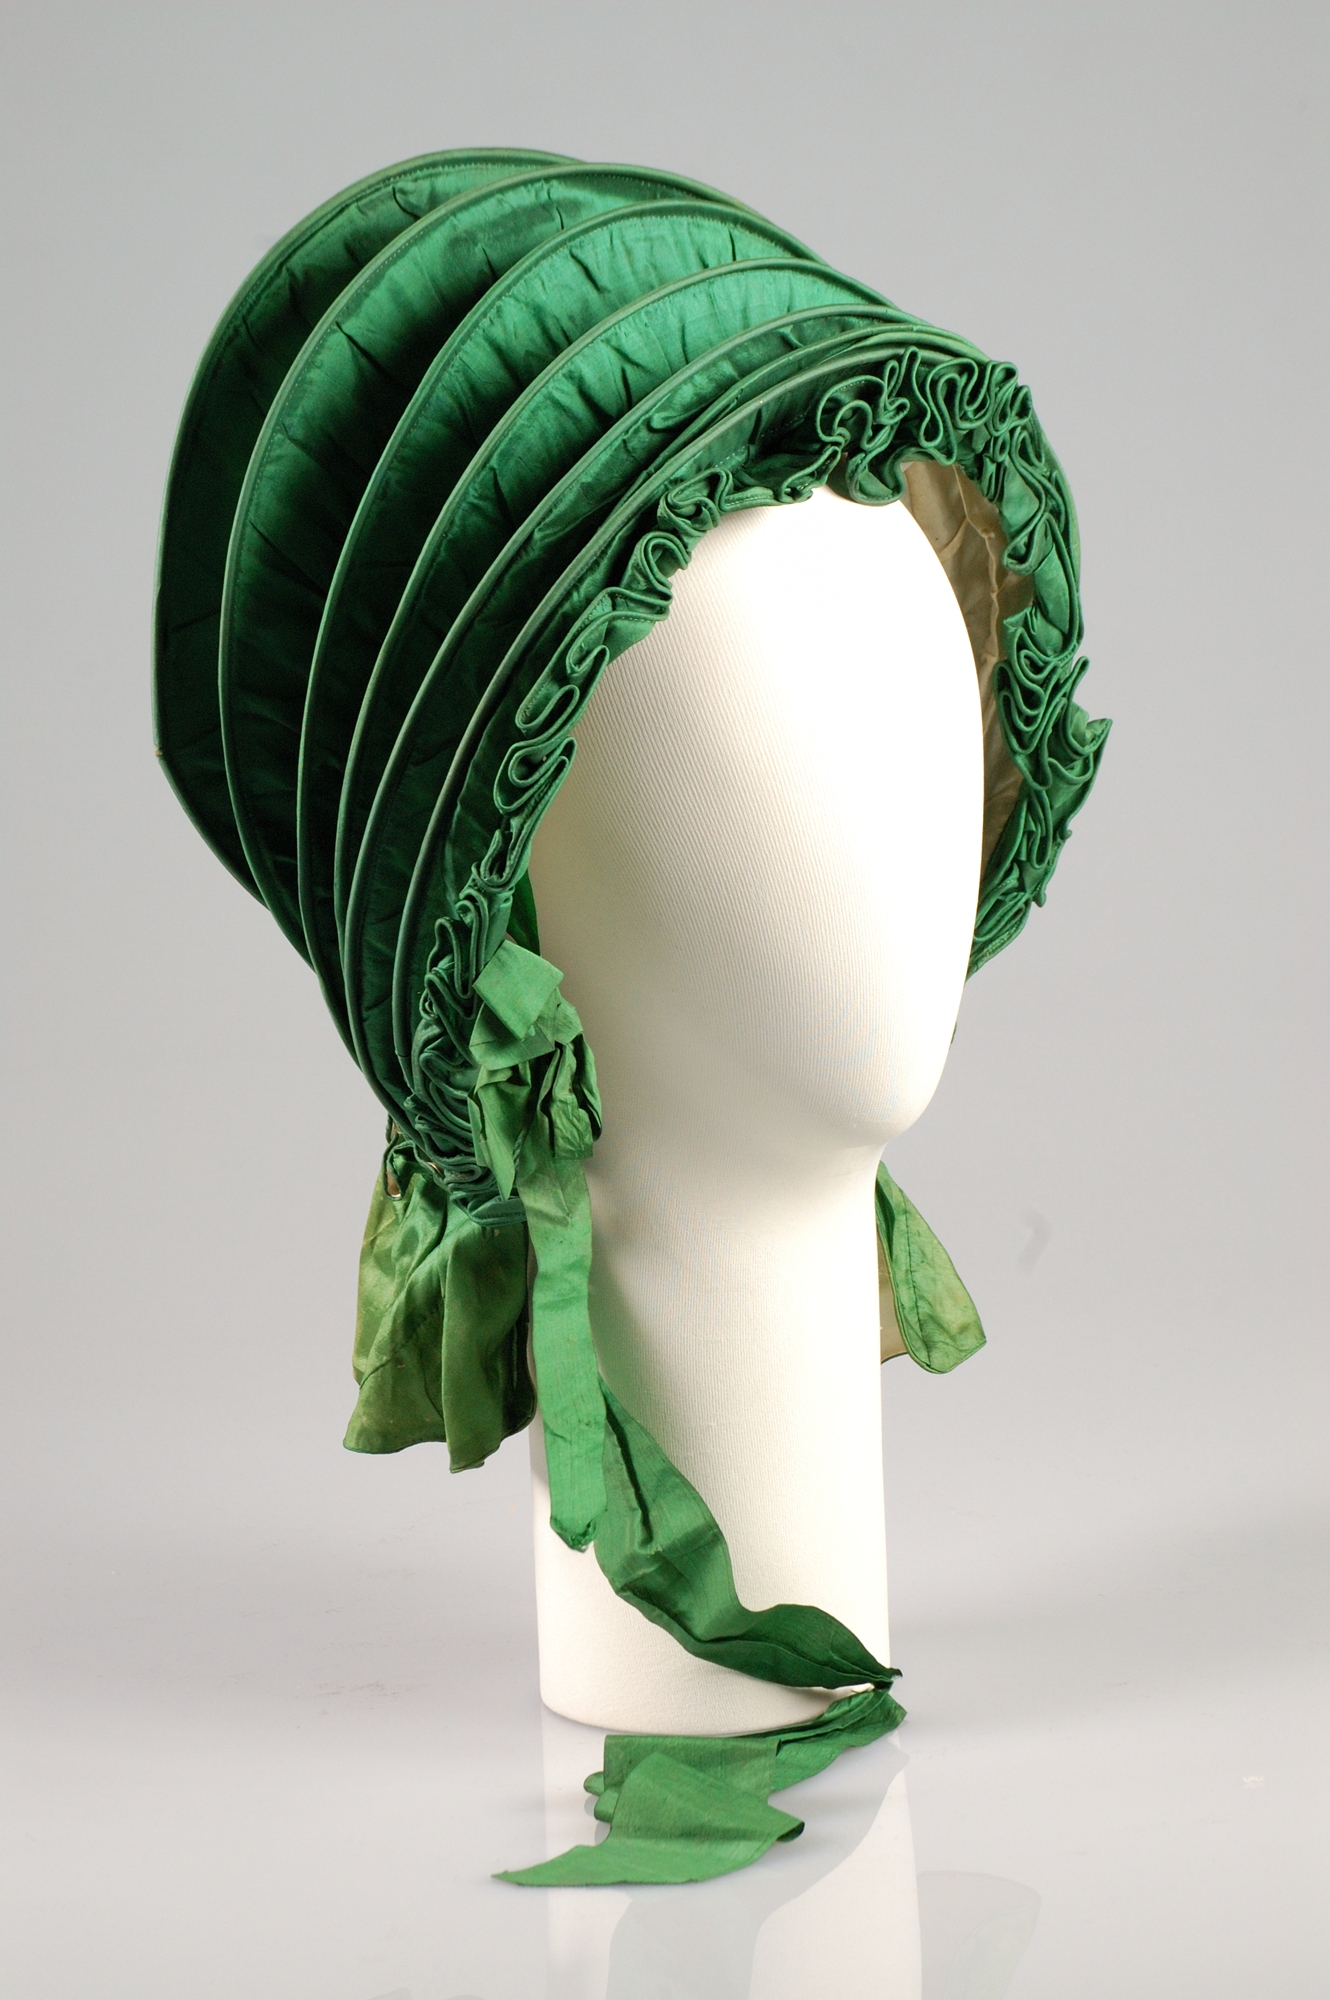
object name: calash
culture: american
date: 1830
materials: silk